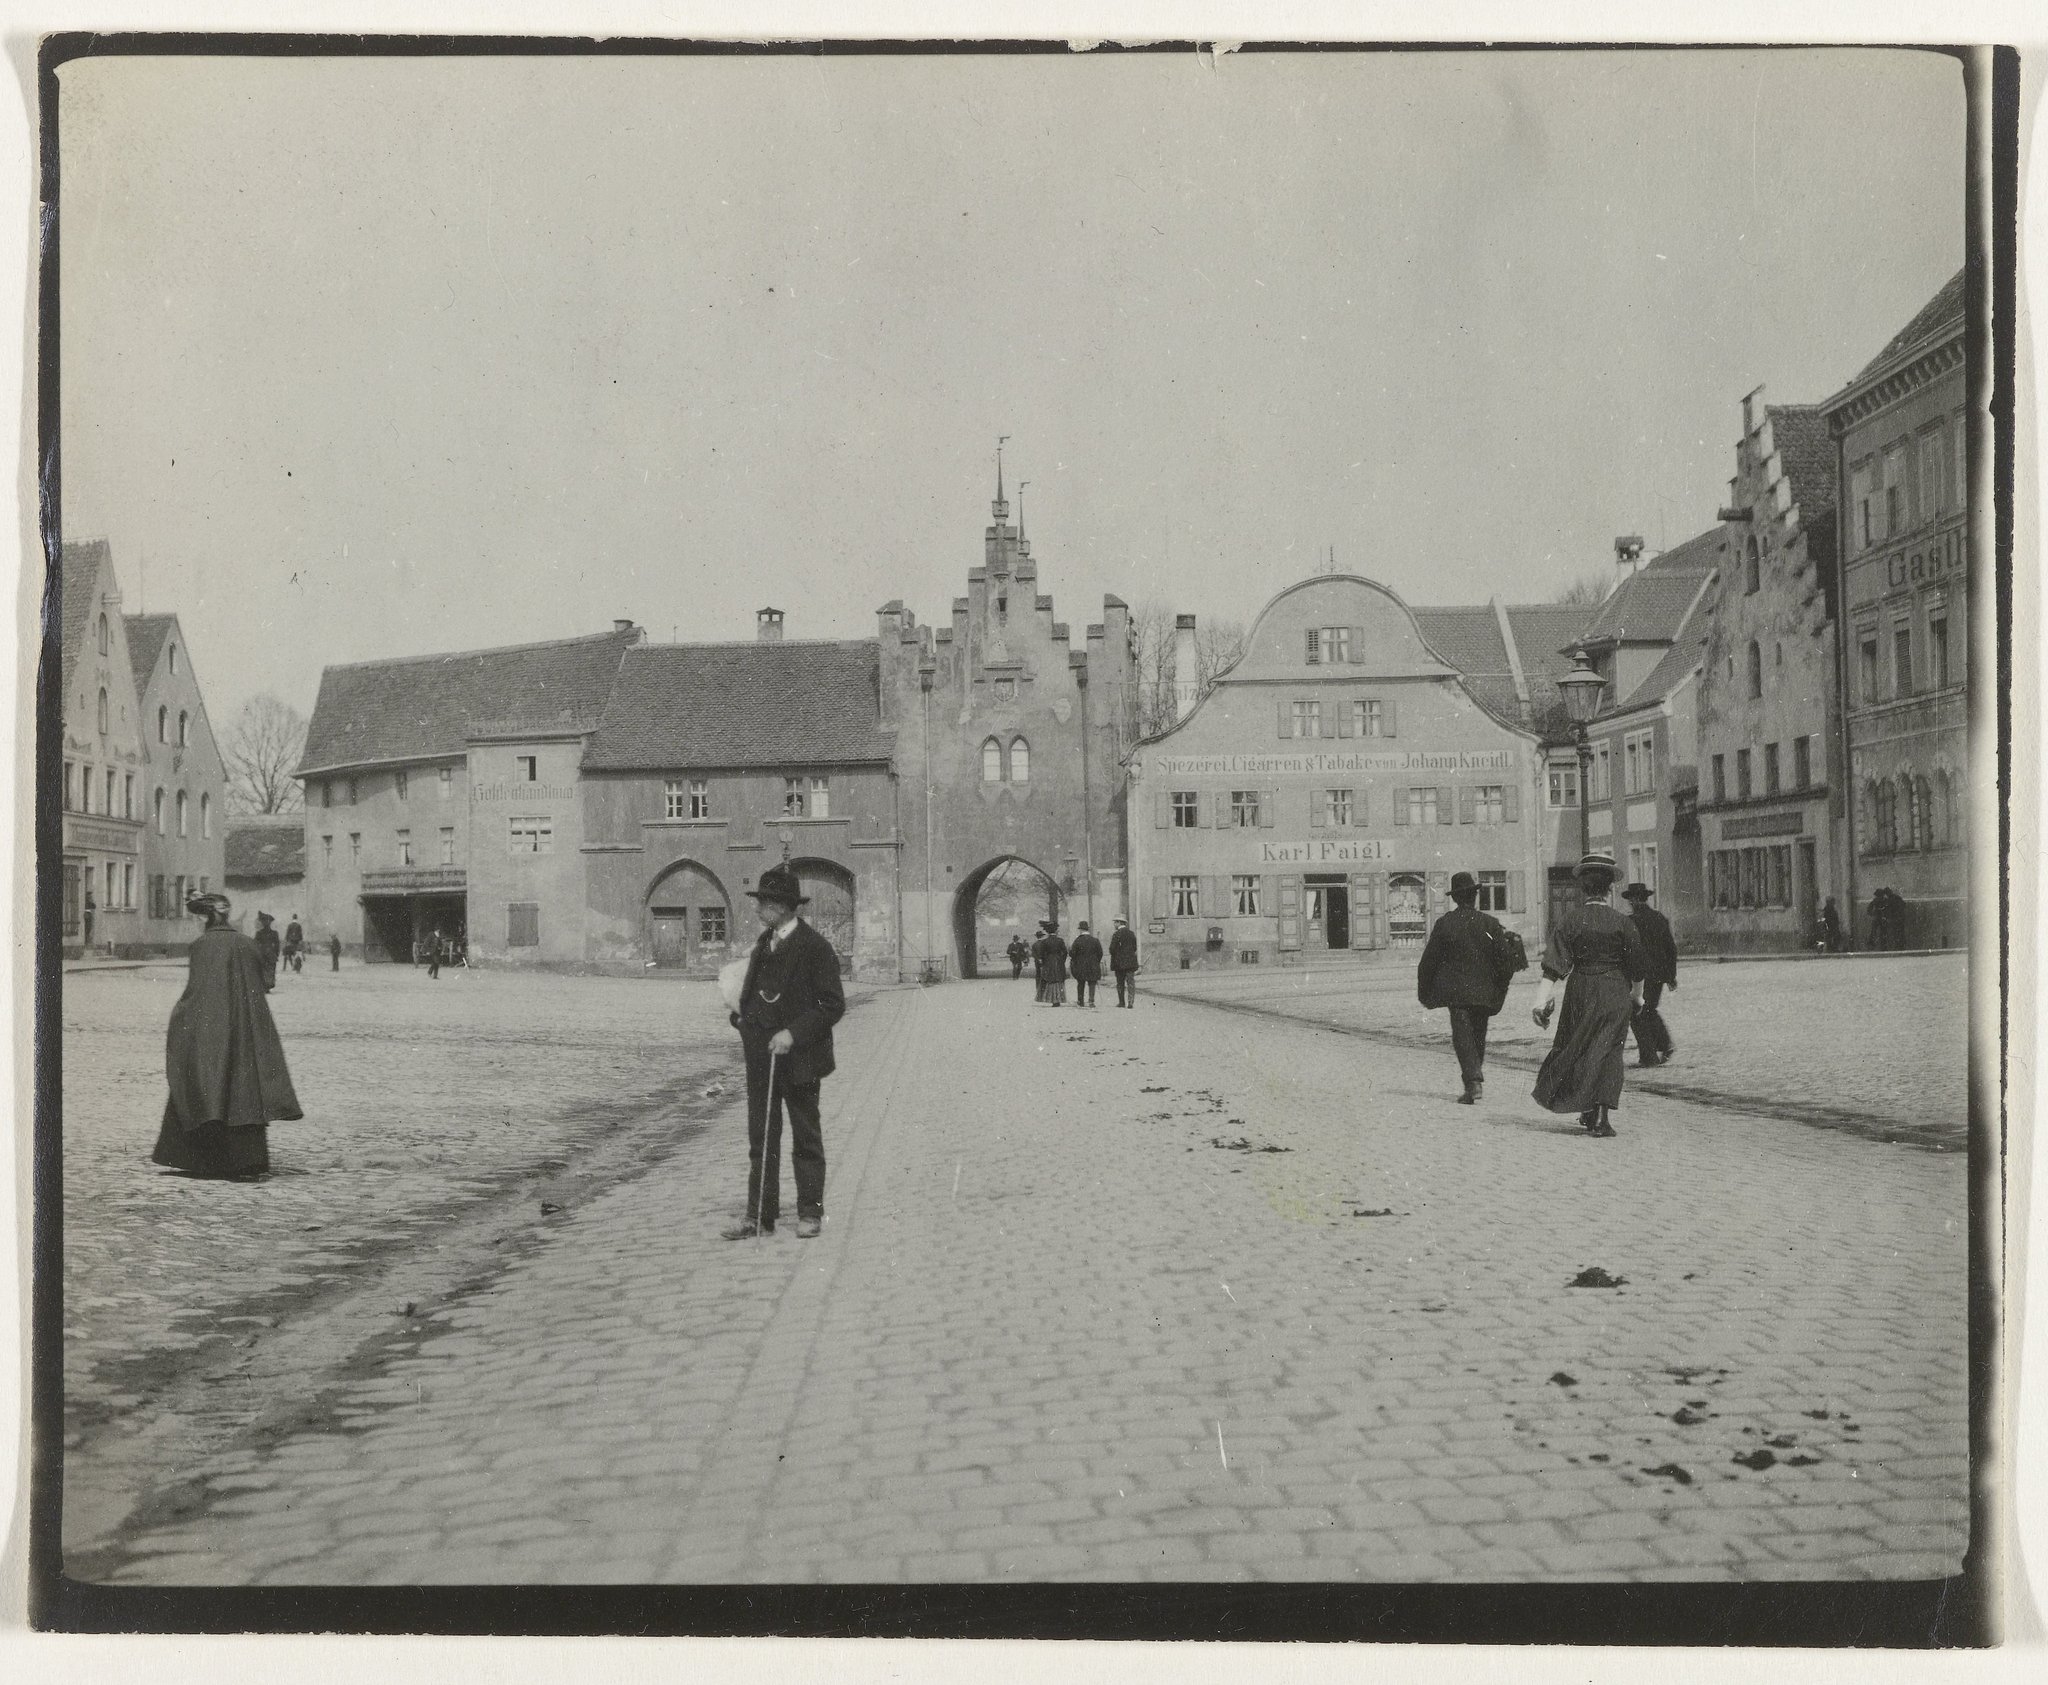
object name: photograph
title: Plein in een stad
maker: Anonymous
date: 1900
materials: paper, photographic support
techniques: gelatin silver print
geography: germany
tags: square, place, circus, etc. (+ city(-scape) with figures, staffage), city-gate (+ city(-scape) with figures, staffage), germany